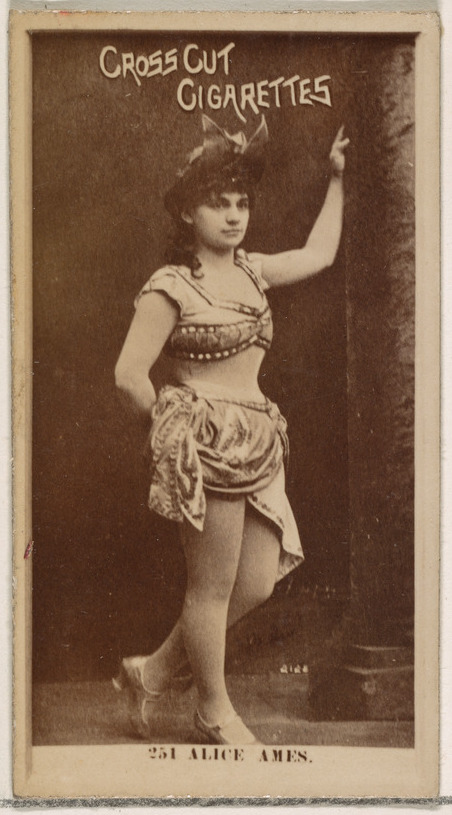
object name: print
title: Card Number 251, Alice Ames, from the Actors and Actresses series (N145-2) issued by Duke Sons & Co. to promote Cross Cut Cigarettes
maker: w. duke, sons & co.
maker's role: publisher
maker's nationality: american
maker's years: 1870-1920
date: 1880-1889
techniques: albumen silver print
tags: portraits,women,actresses